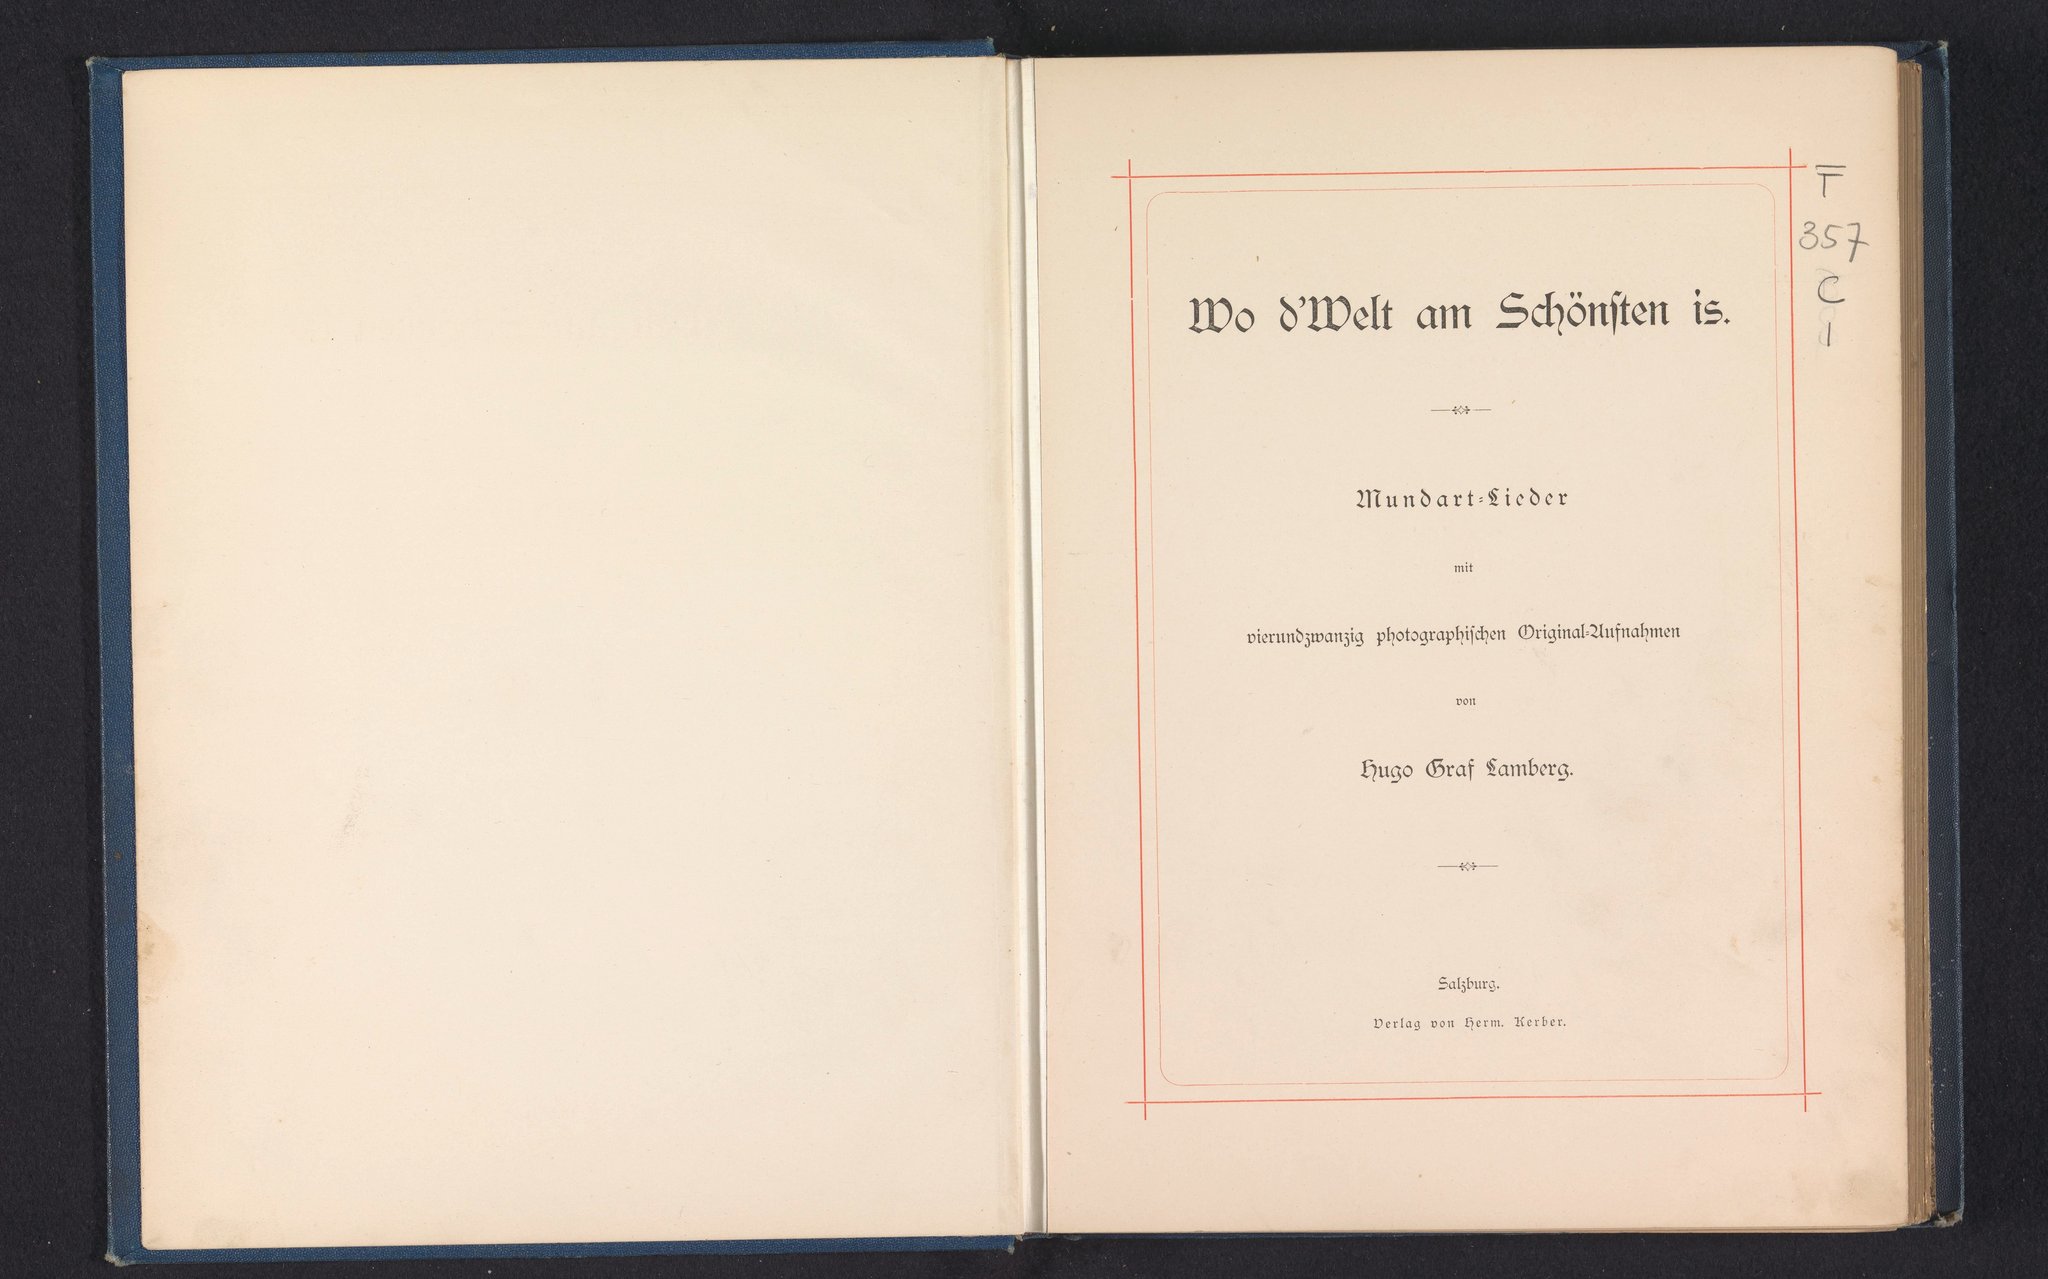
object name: book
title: Wo d'Welt am Schönsten is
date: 1882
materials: cardboard, linen, paper, photographic support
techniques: albumen print, printing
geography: salzburg